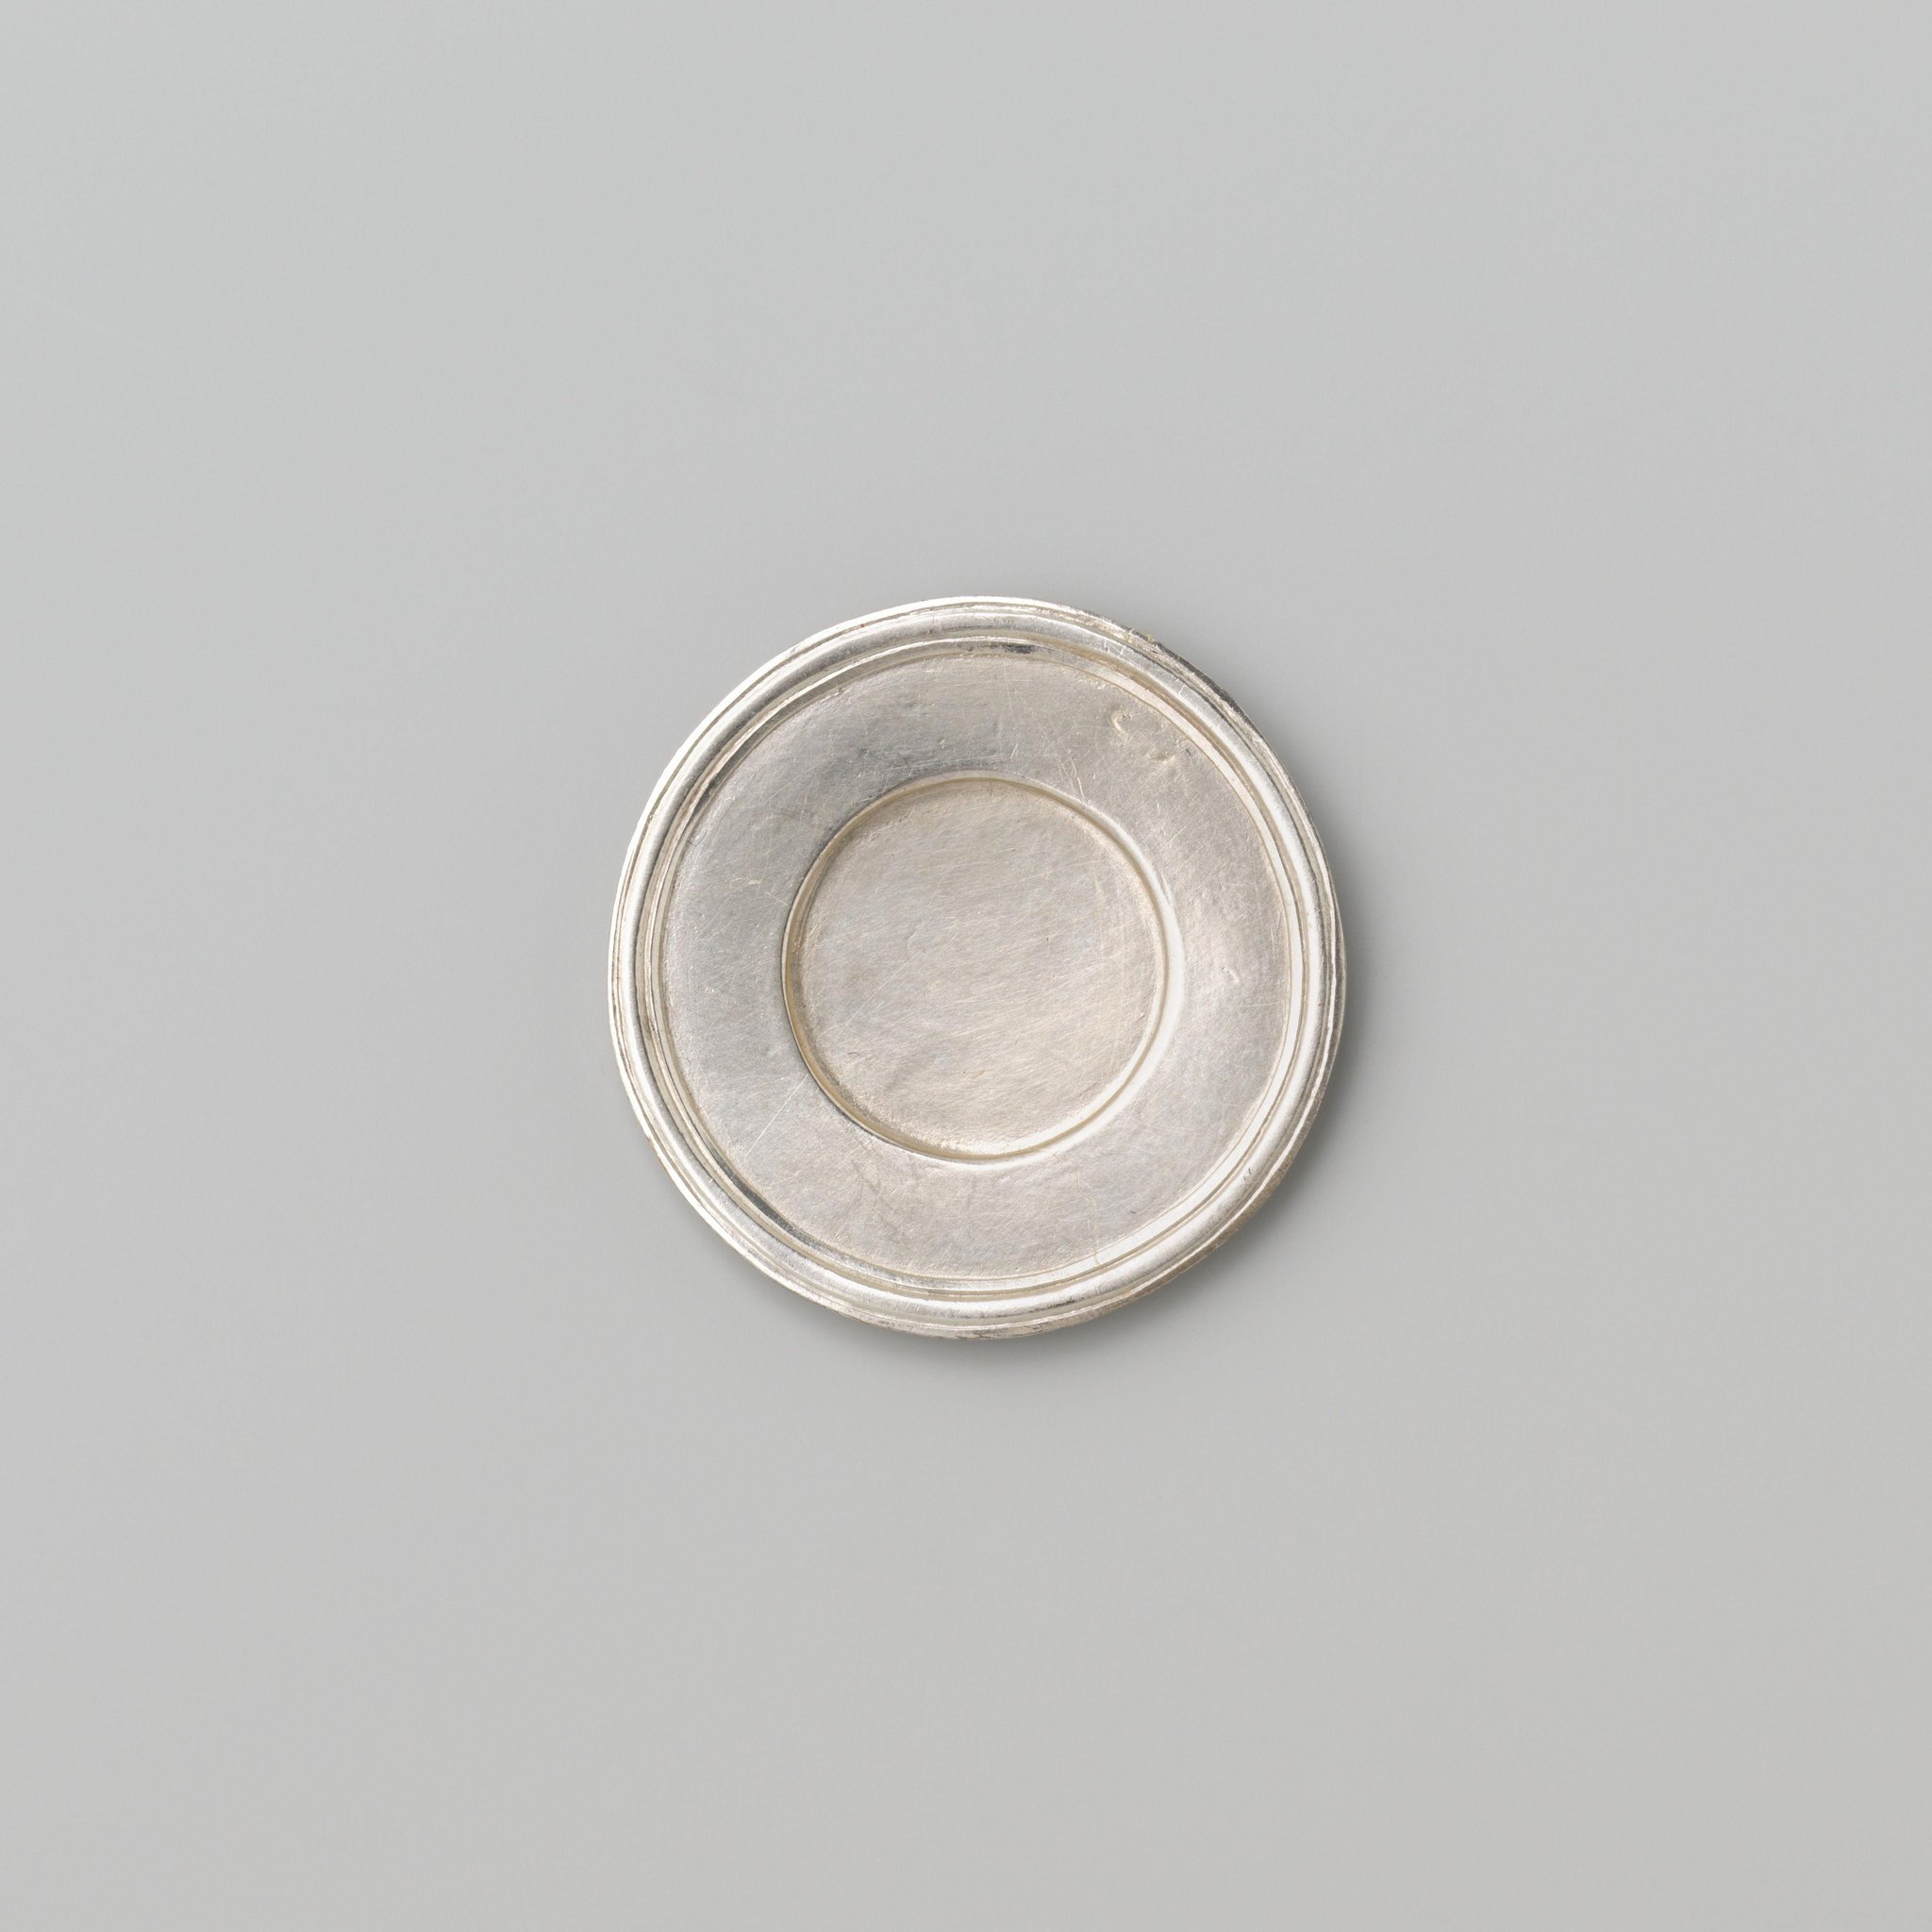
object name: miniature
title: Zilverkleurige schoteltje met brede platte geprofileerde rand.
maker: Anonymous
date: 1700-1710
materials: copper alloy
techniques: silvering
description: Zilverkleurige schotel met brede, platte geprofileerde rand.